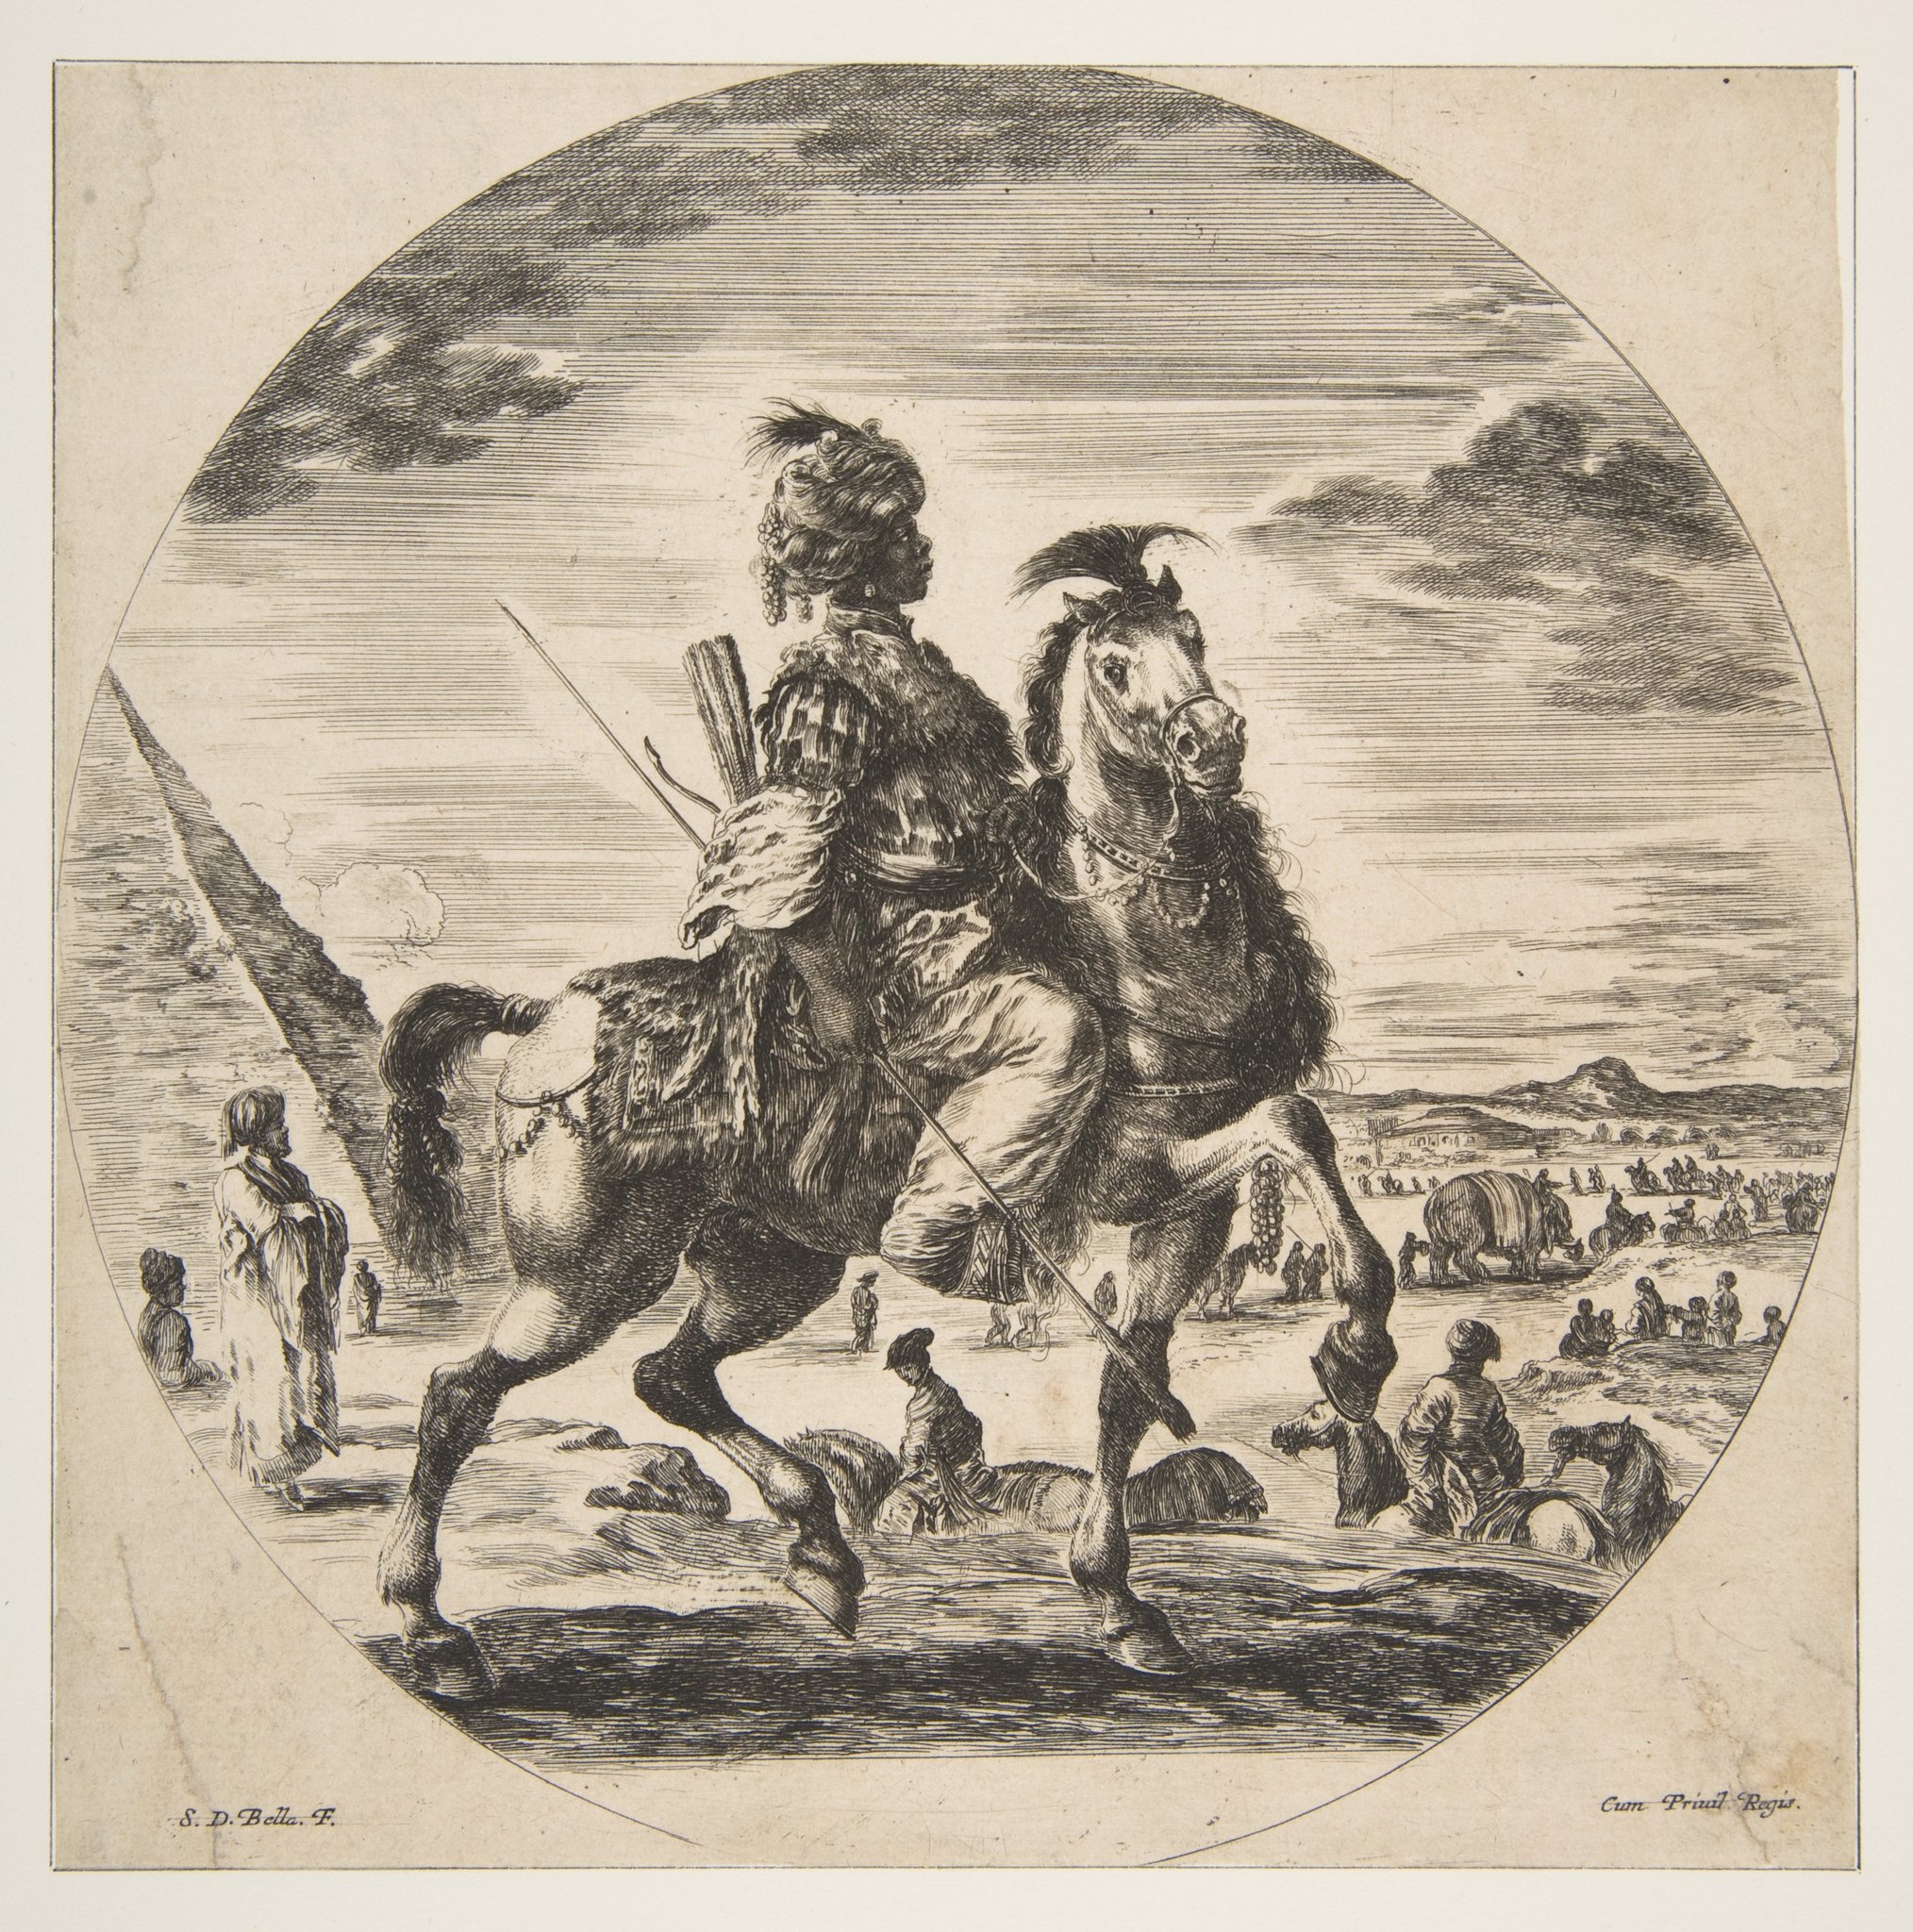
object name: print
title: Moorish horseman in profile facing right, in the background a pyramid at left, many figures and an elephant, from 'Figures on Horseback' (Cavaliers nègres, polonais et hongrois)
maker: stefano della bella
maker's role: artist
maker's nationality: italian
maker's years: 1610-1664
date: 1651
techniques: etching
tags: pyramids,men,elephants,horses